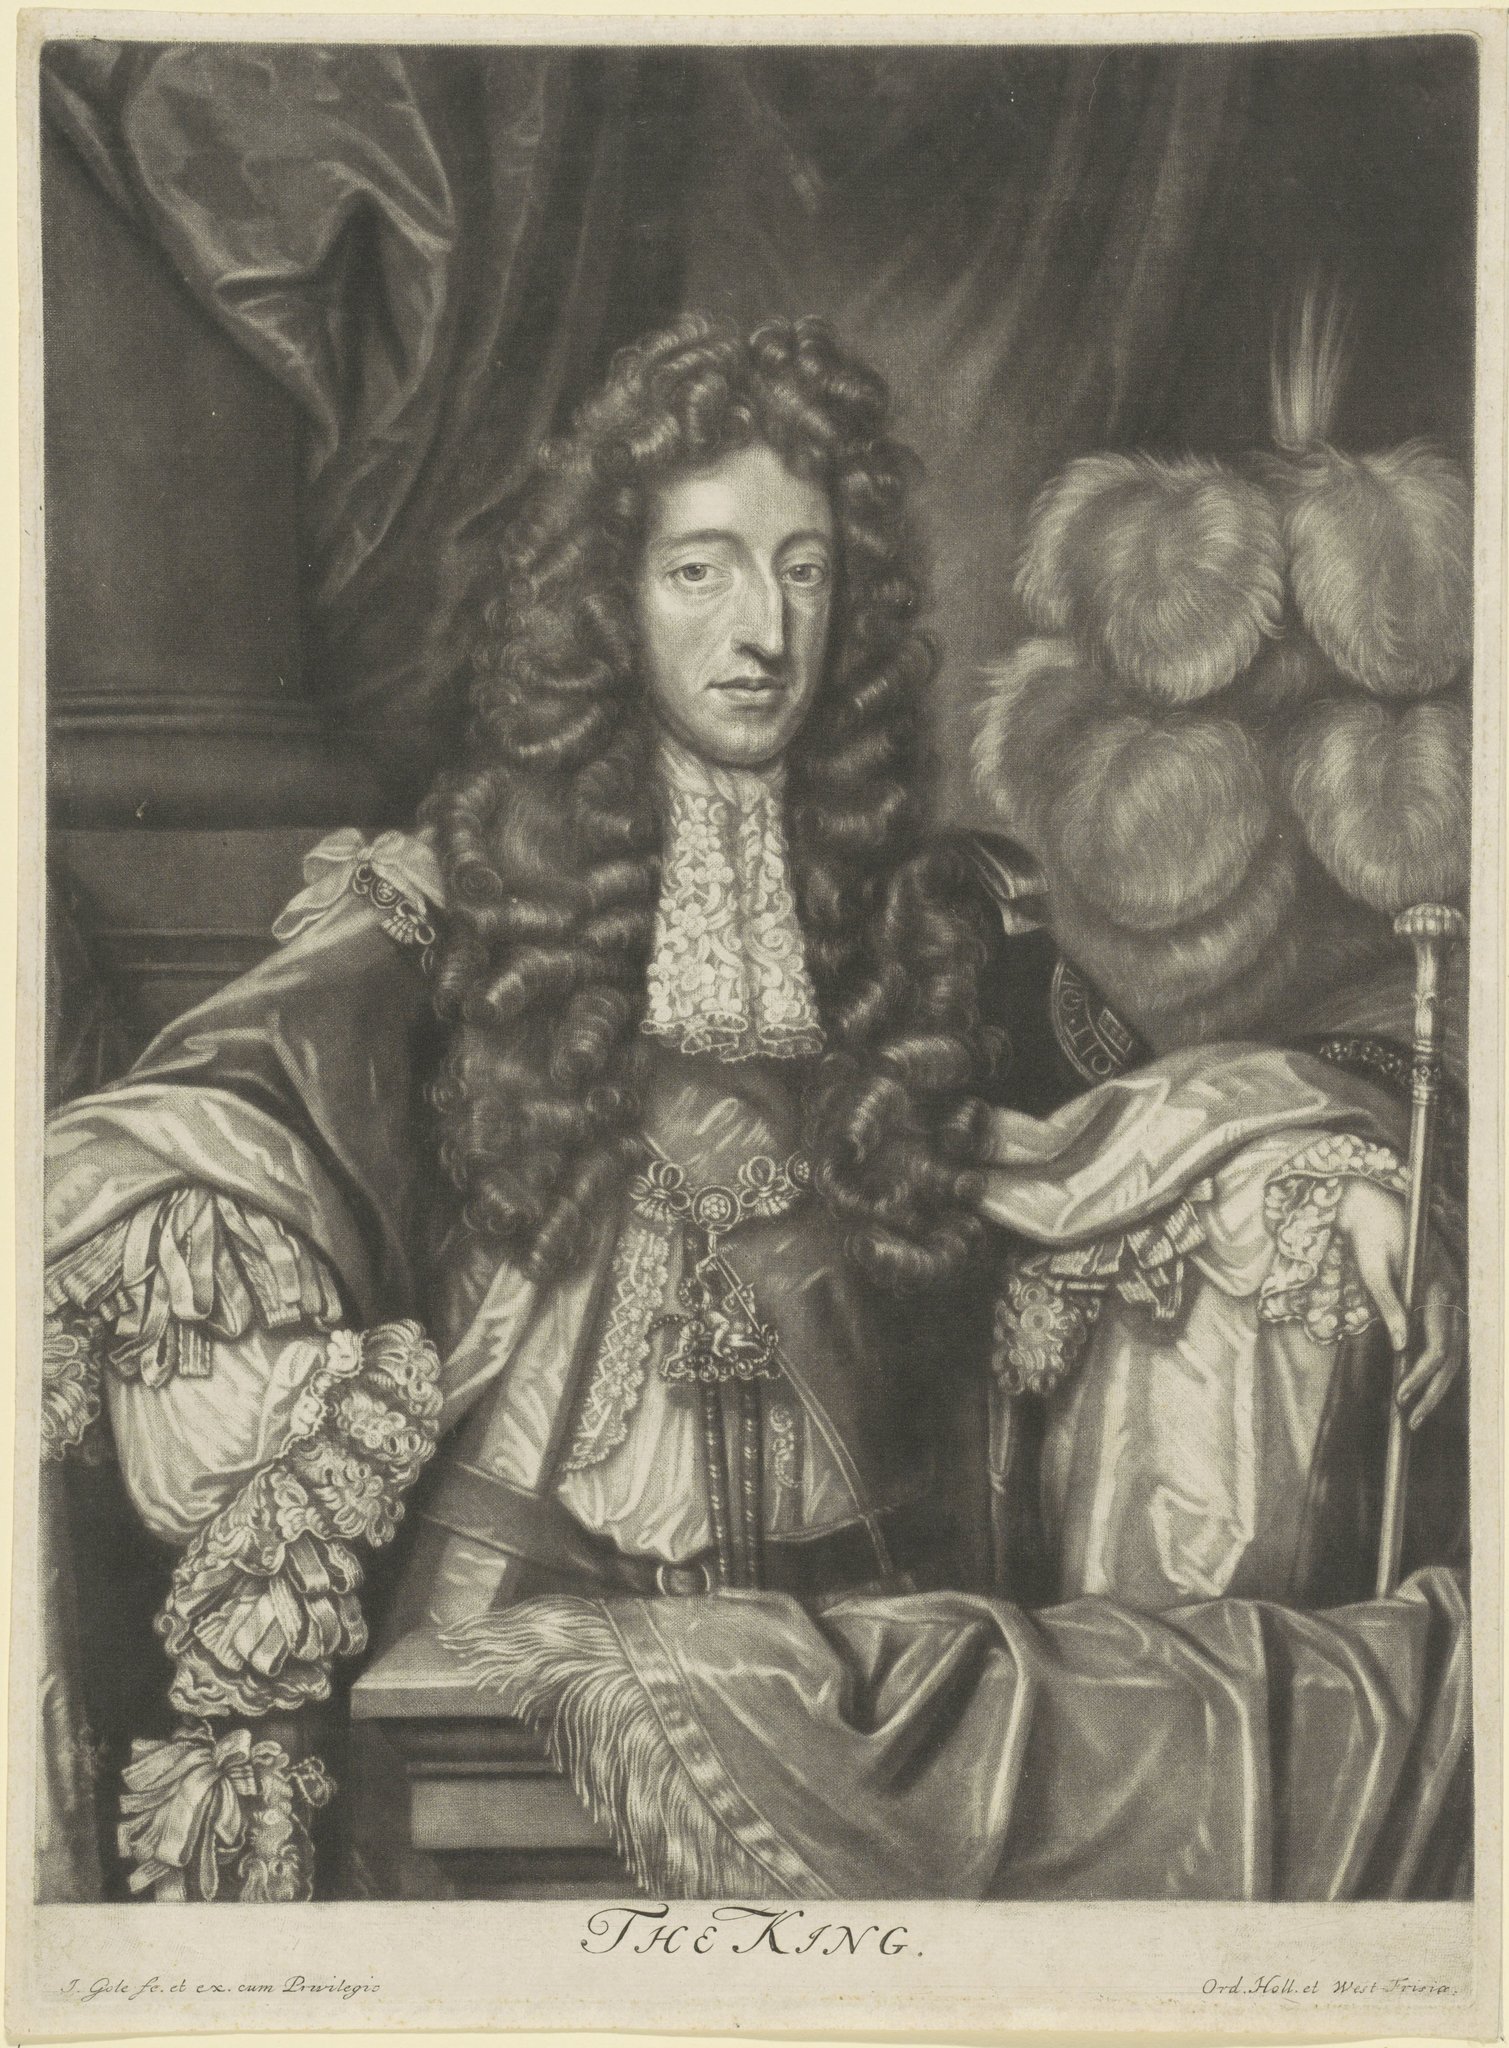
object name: print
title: Portret van Willem III, prins van Oranje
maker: jacob gole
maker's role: print maker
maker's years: 1660-1724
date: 1688-1724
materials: paper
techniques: mezzotint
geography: amsterdam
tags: the hague, william iii (prince of orange and king of england, scotland, and ireland), knighthood order (garter) - insignia of a knighthood order, e.g.: badge, chain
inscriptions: collector's mark: Lugt 2228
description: Portret van Willem III. Hij staat achter een balustrade met daarop een tapijt. In zijn linkerhand een scepter. Op de achtergrond een baret met veren. In de ondermarge zijn titel.